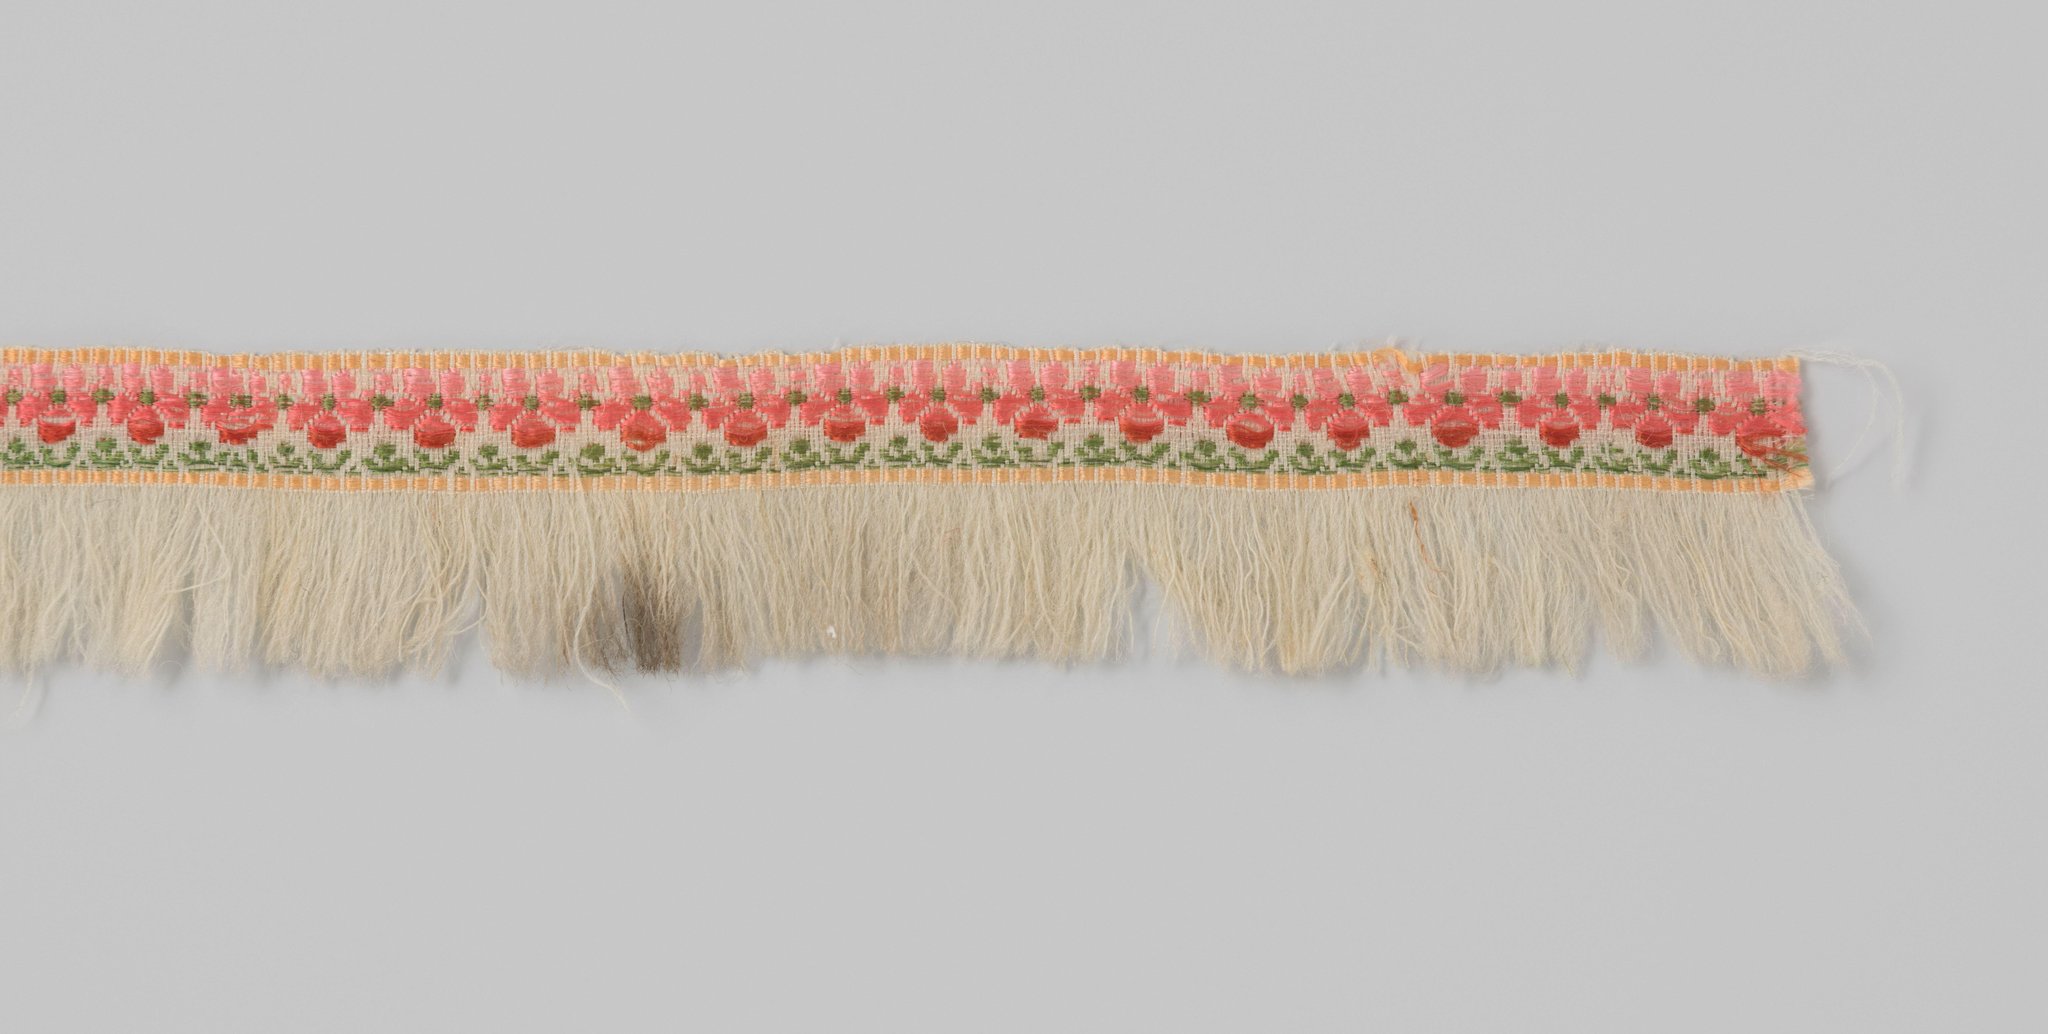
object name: stoelbekleding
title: Passement van geweven witte wol, dat aan één van de lange kanten is uitgehaald zodat er een franje is ontstaan; de wol is over de lengte versierd met geborduurde bloemen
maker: Anonymous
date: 1750-1790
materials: silk, wool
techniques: embroidered, weave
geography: netherlands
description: Passement van witte wol, versierd met gekleurd borduurwerk. Het passement bestaat uit een band van geweven wol, dat aan één van de lange kanten is uitgehaald zodat er een franje is ontstaan. De wol is over de lengte versierd met geborduurde bloemen in groen en verschillende tinten roze; langs de randen loopt een oranjekleurige geborduurde streep. Mogelijk een passement voor kleding of meubelbekleding.